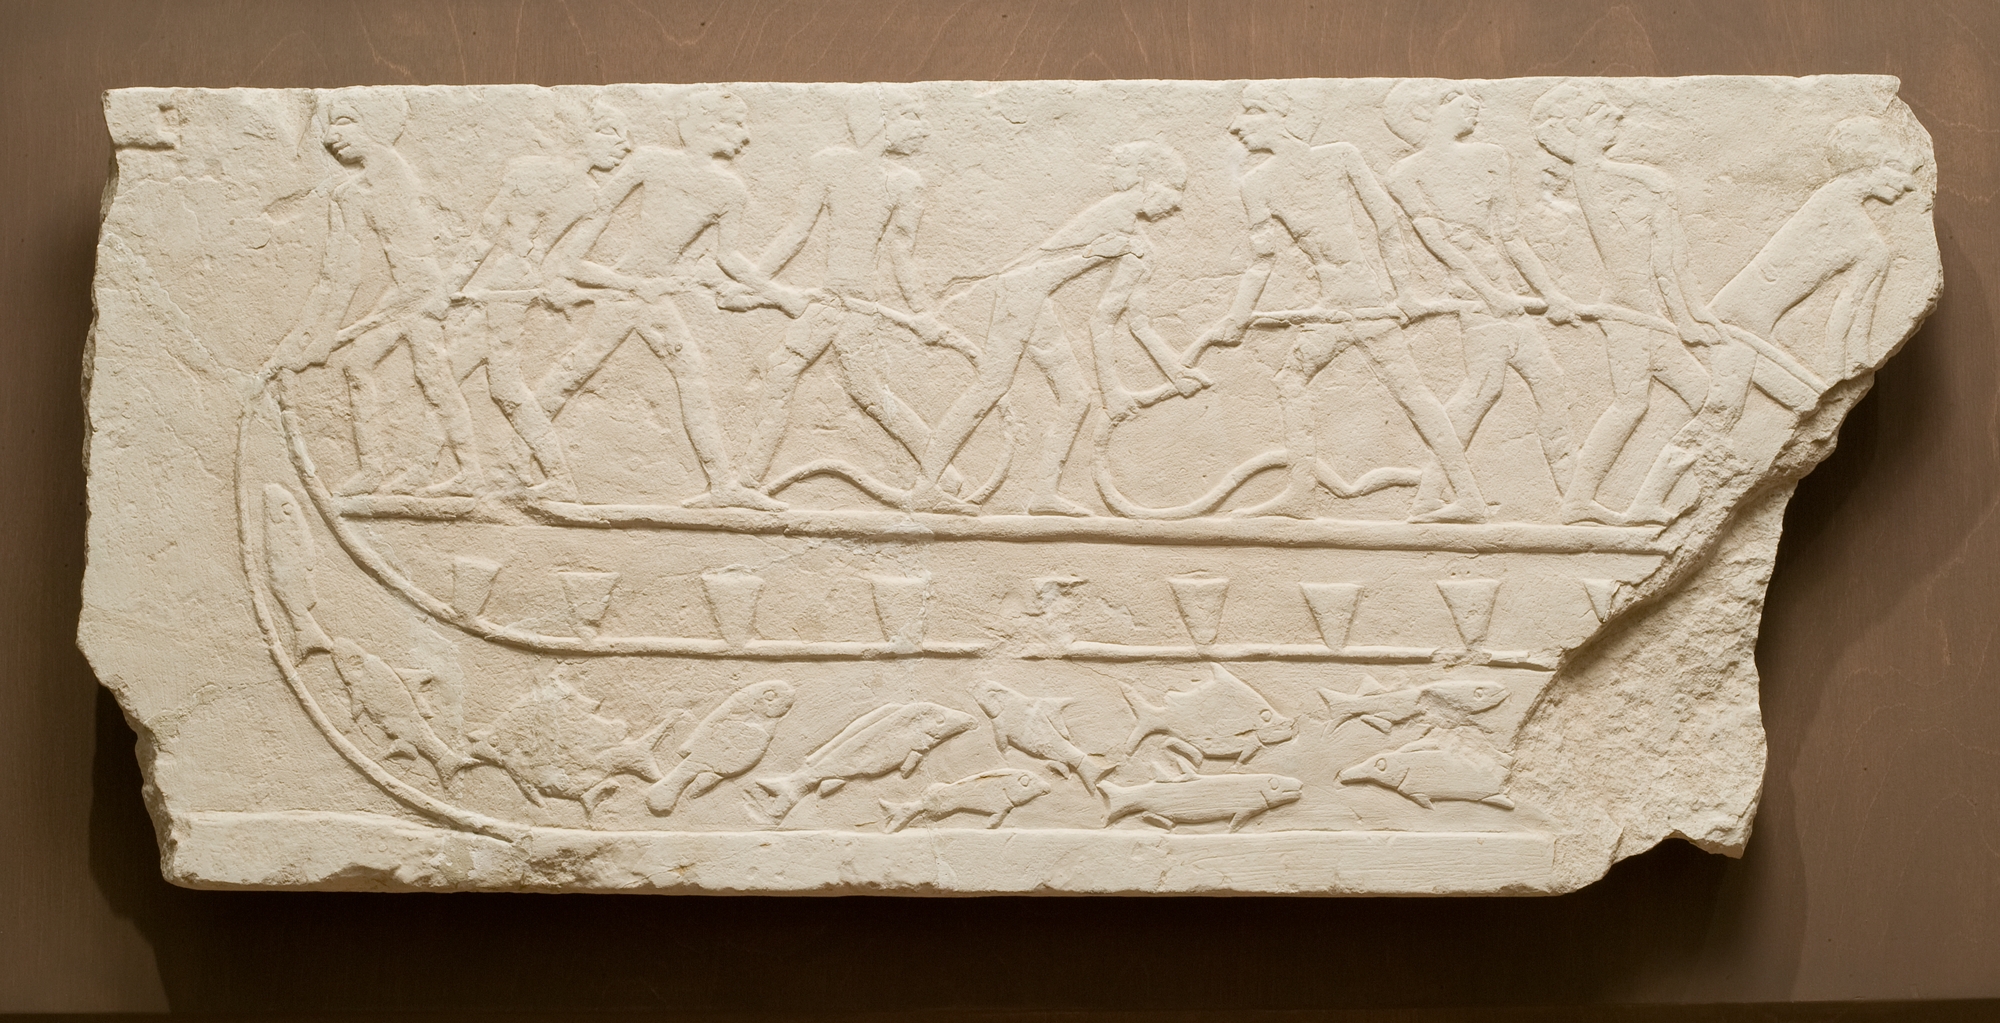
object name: relief, fishing scene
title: Relief fragment showing fishing scene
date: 2575-2465 BCE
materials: limestone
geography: egypt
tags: men,fishing,fish